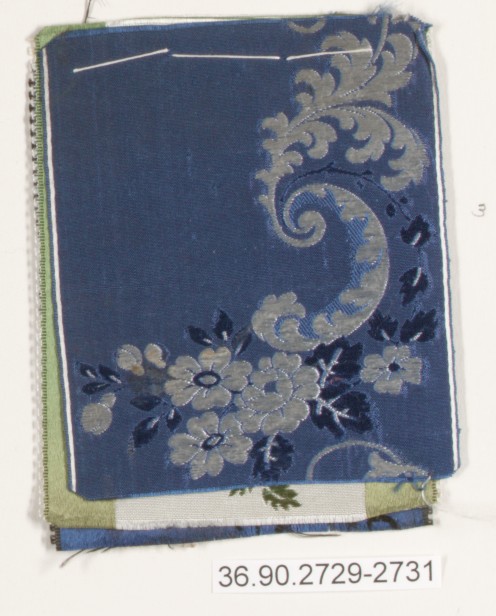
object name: ribbon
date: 1801-1900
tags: flowers